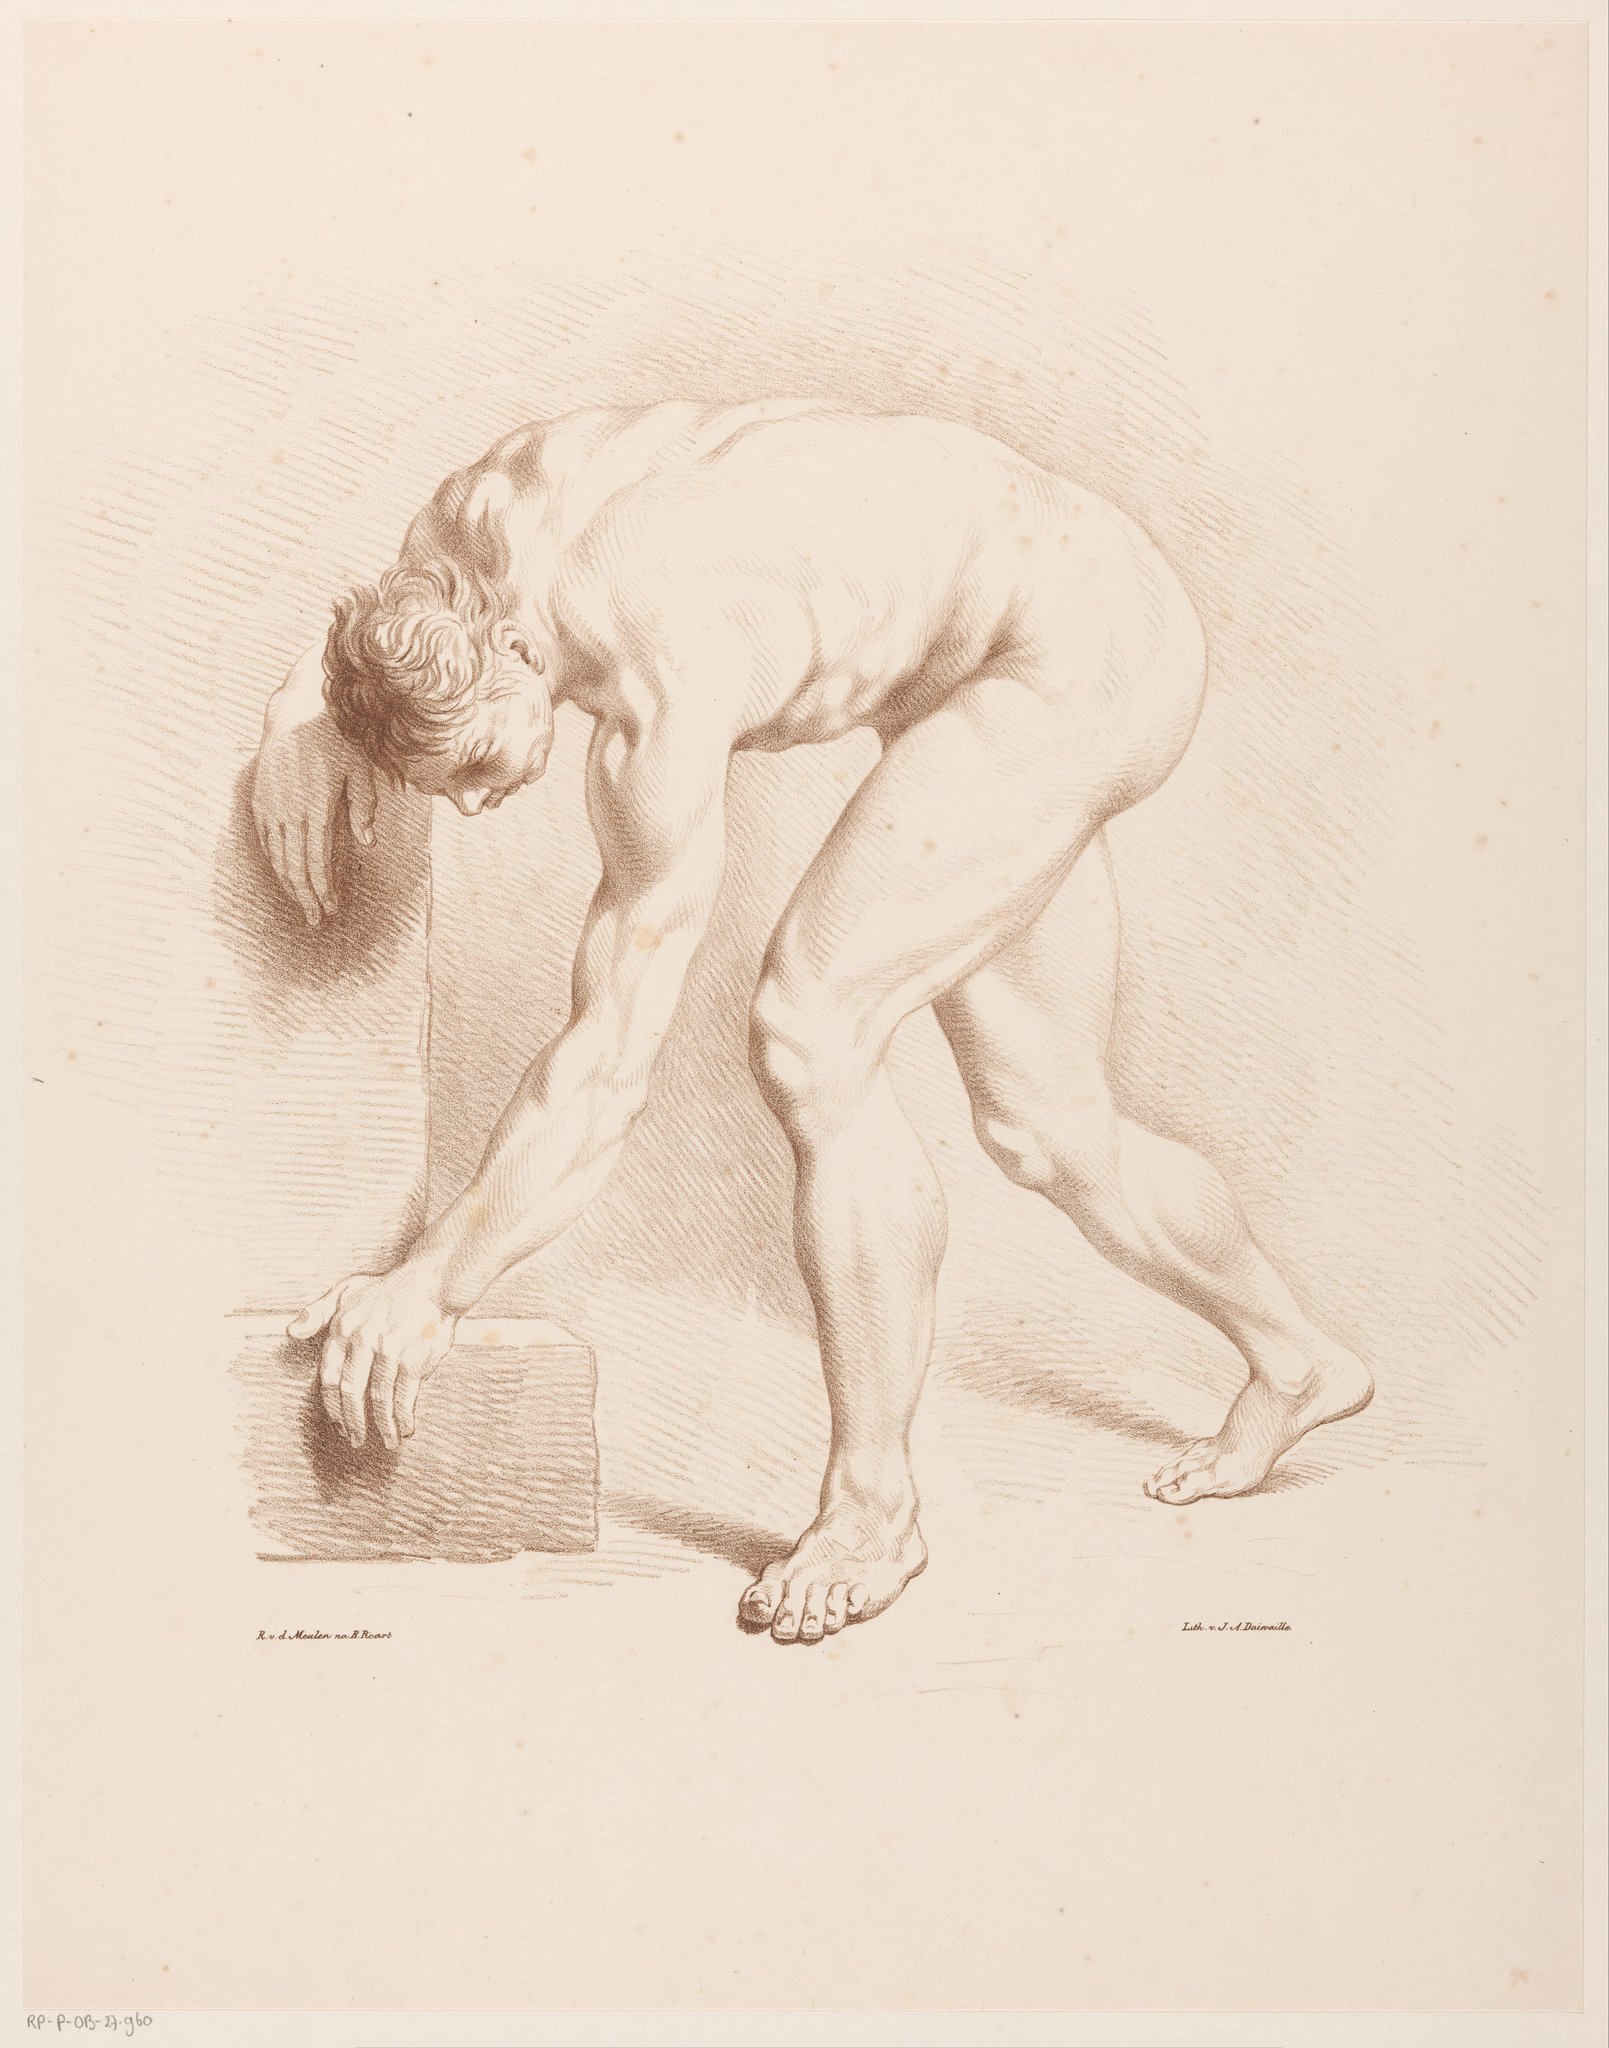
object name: print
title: Gebogen naakte man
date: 1820-1833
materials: paper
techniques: lithograph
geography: amsterdam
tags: bending figure, the (nude) human figure; 'corpo humano' (ripa)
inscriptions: collector's mark: Lugt 2228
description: Het rechterbeen van de man staat verder naar achteren. Met zijn rechter onderarm leunt hij op een muur of blok. Met zijn linkerhand rust hij op een lagergelegen blok.